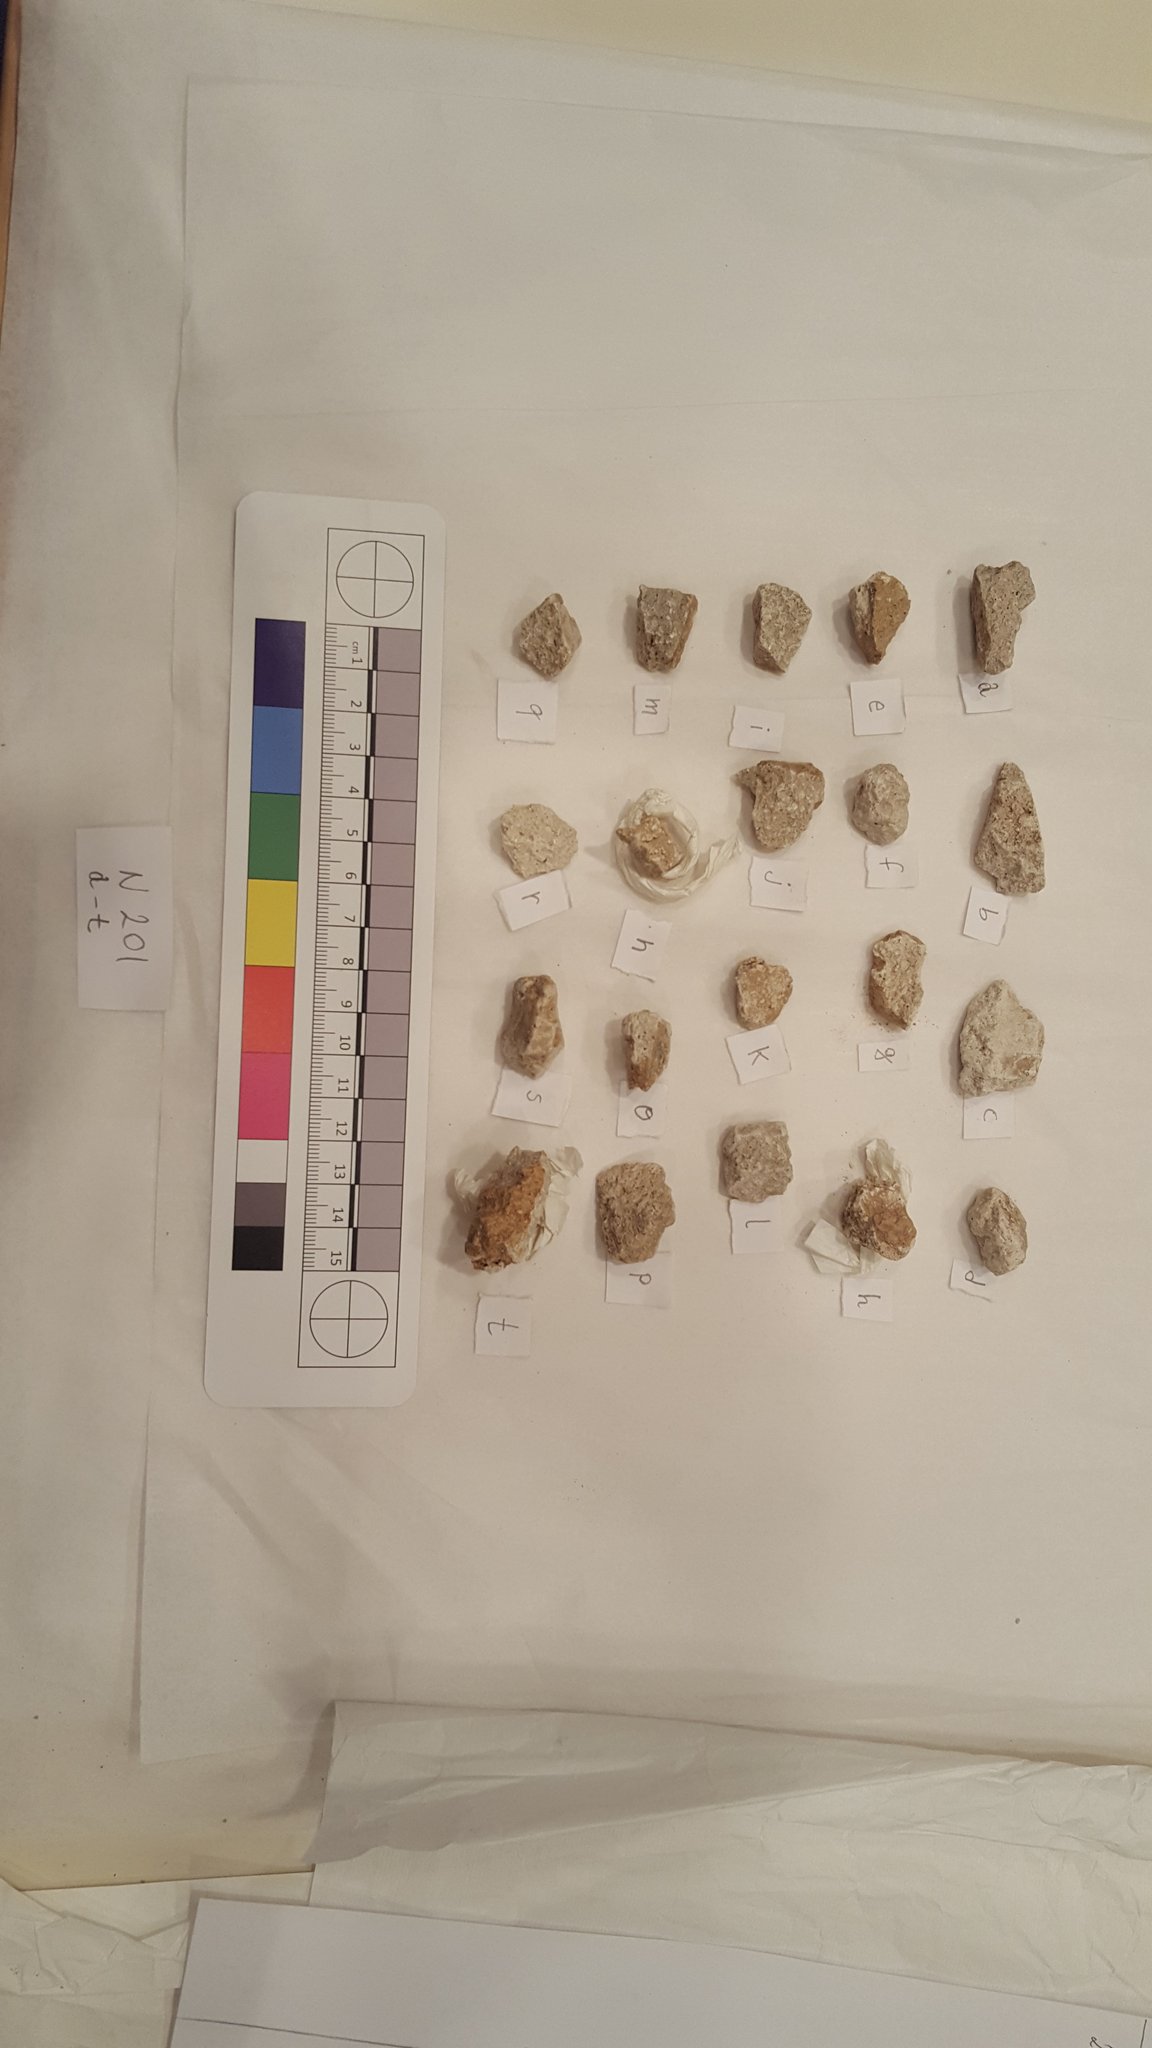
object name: fragment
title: Stucco Fragment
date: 701-1200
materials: plaster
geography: iran